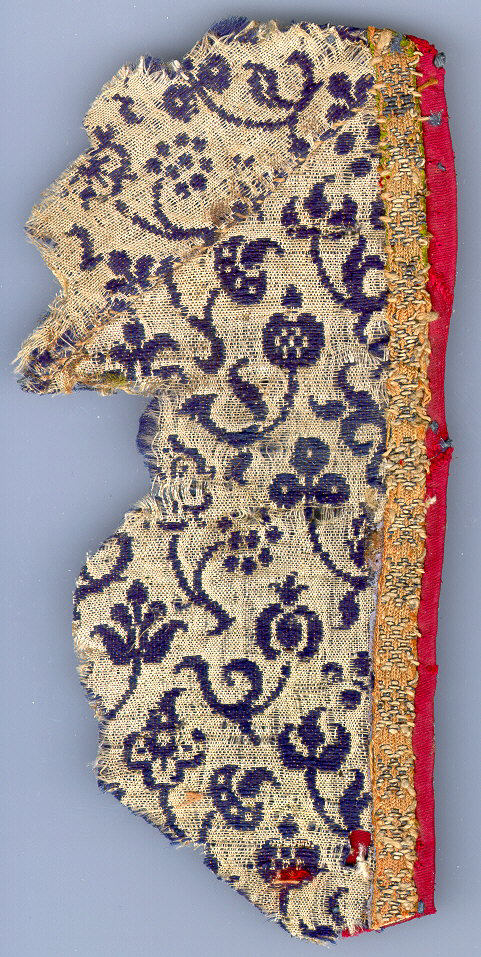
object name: textile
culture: italian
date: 1500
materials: silk, wool